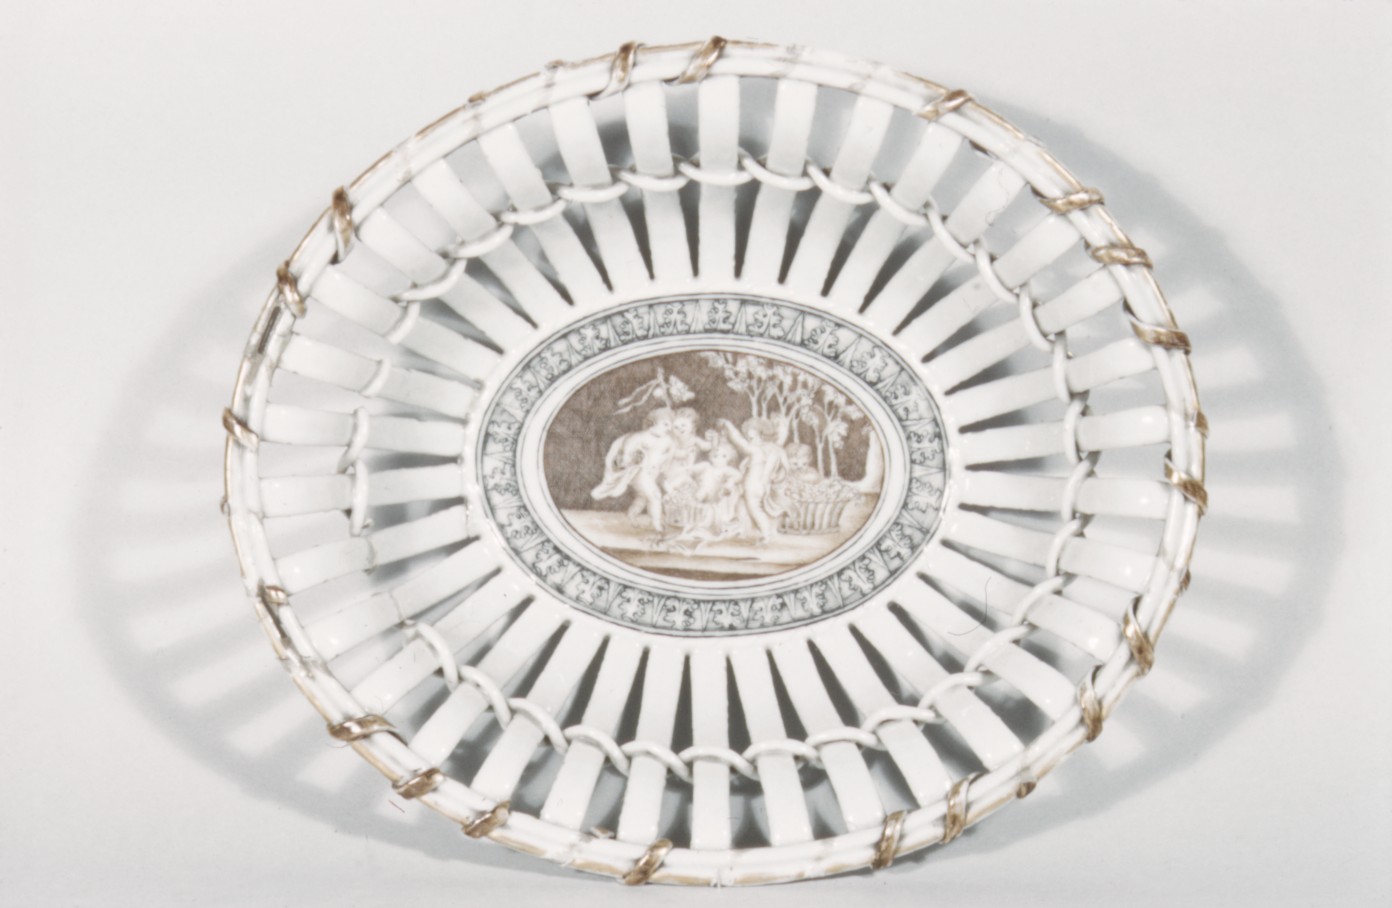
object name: basket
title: Basket (part of a set)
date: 1785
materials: hard paste porcelain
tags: putti